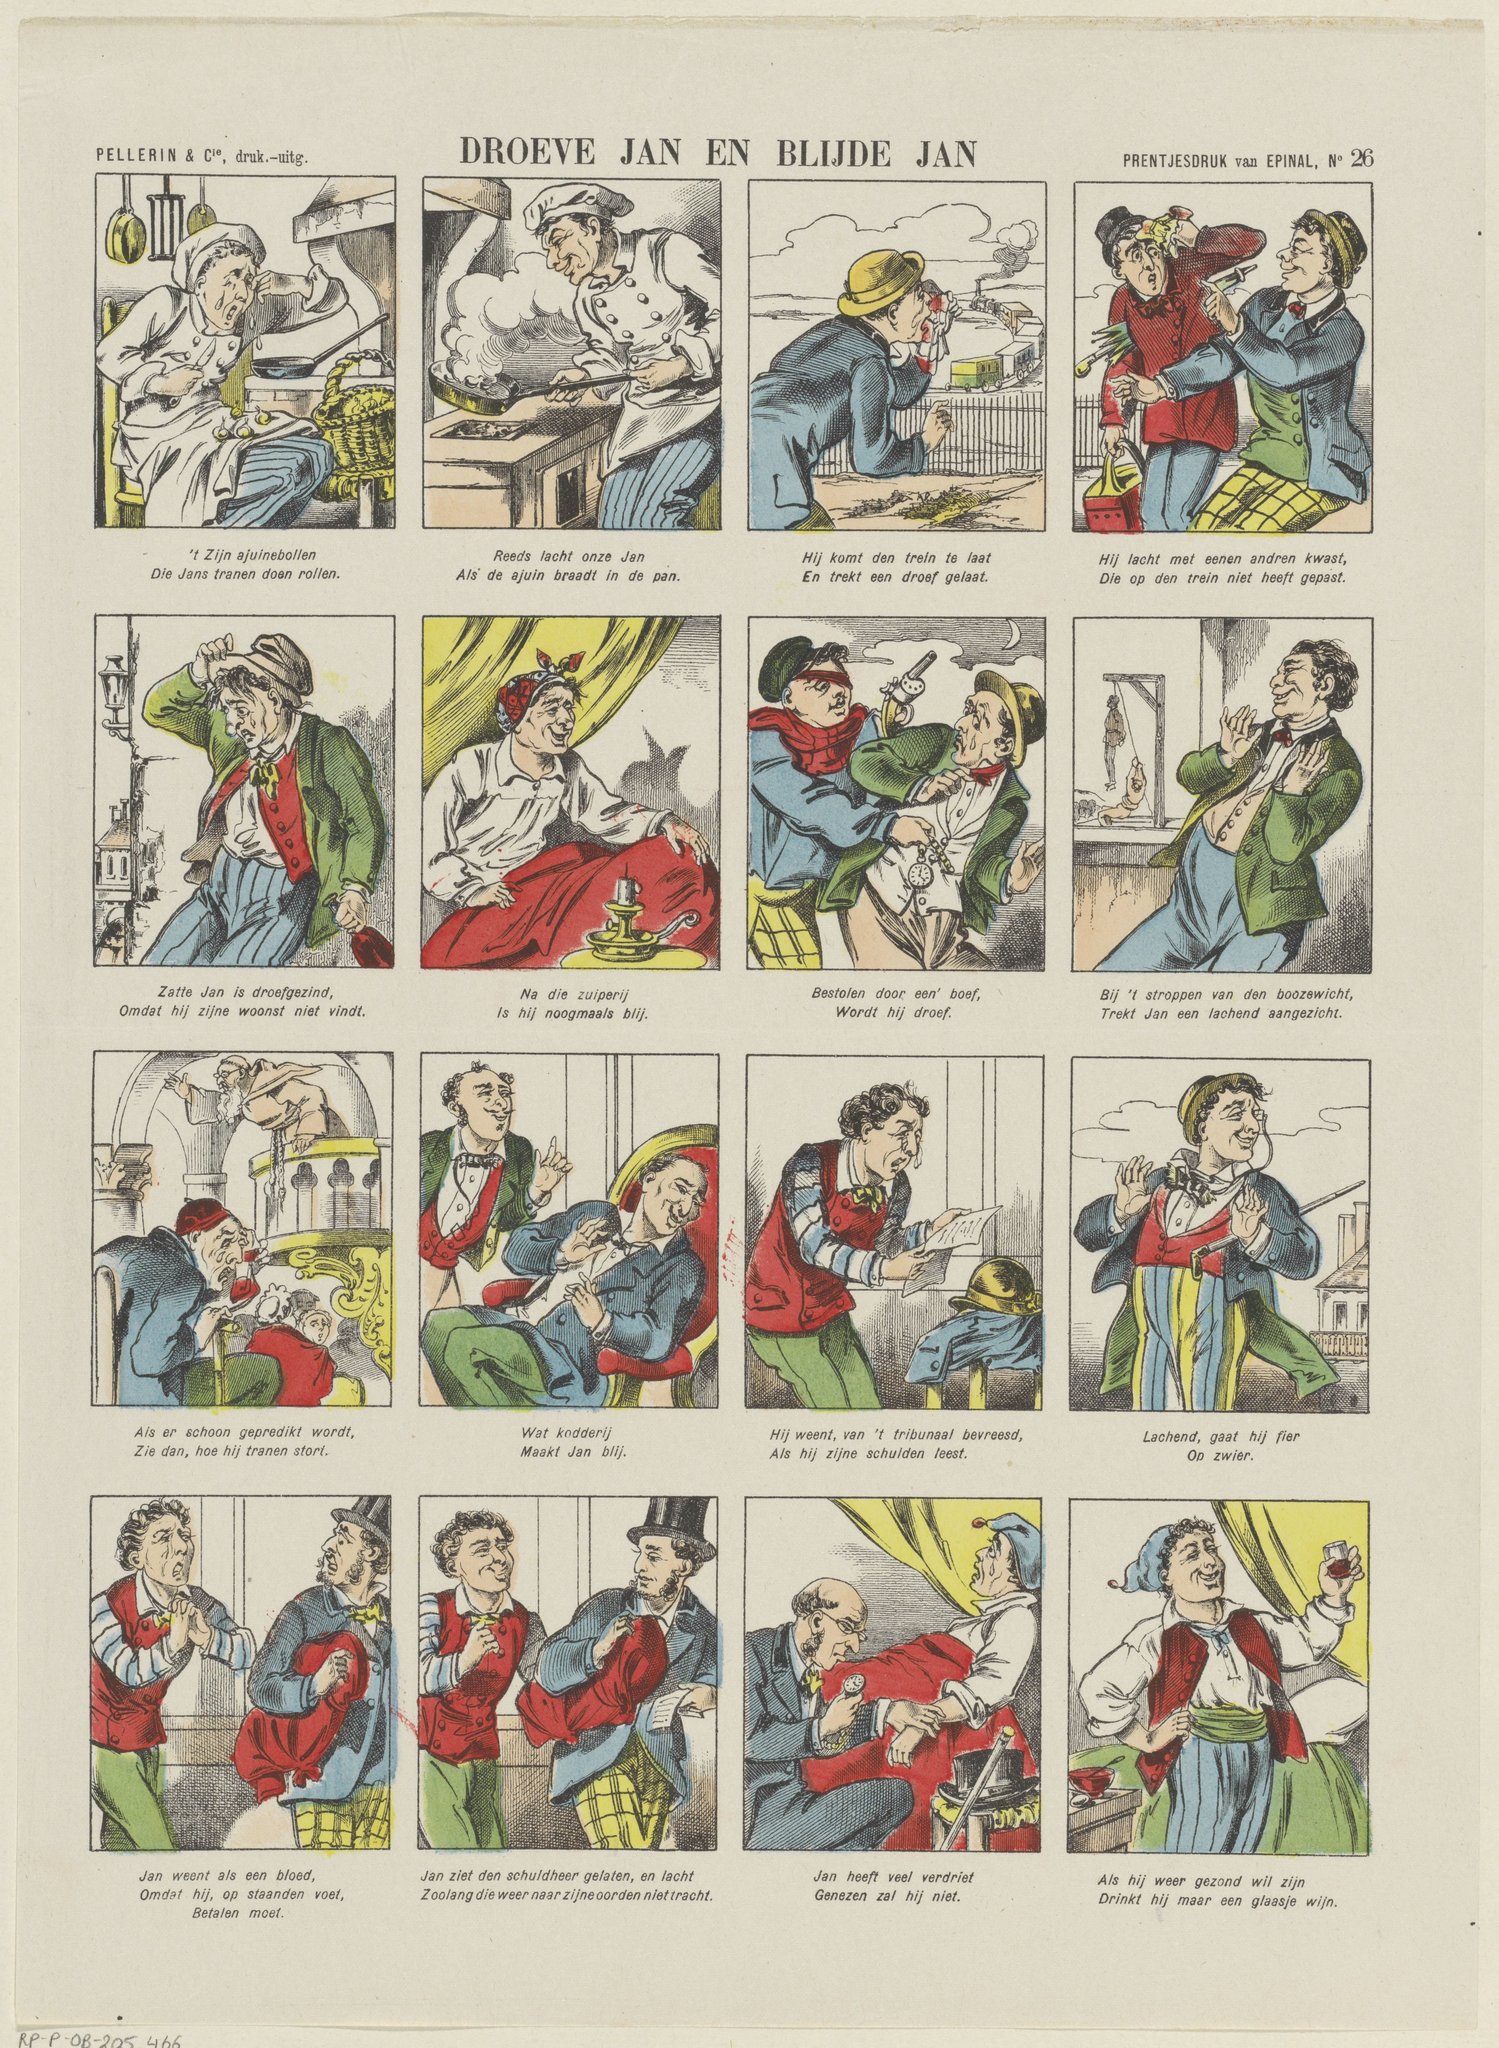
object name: print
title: Droeve Jan en blijde Jan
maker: Anonymous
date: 1902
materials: paper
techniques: colour, letterpress printing, lithograph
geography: epinal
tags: unhappiness; 'infelicità' (ripa), happiness, felicity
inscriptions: collector's mark: Lugt 2760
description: Blad met 16 voorstellingen van Jan en de dingen waar hij droevig en waar hij blij van wordt. Onder elke afbeelding een onderschrift. Genummerd rechtsboven: No 26.